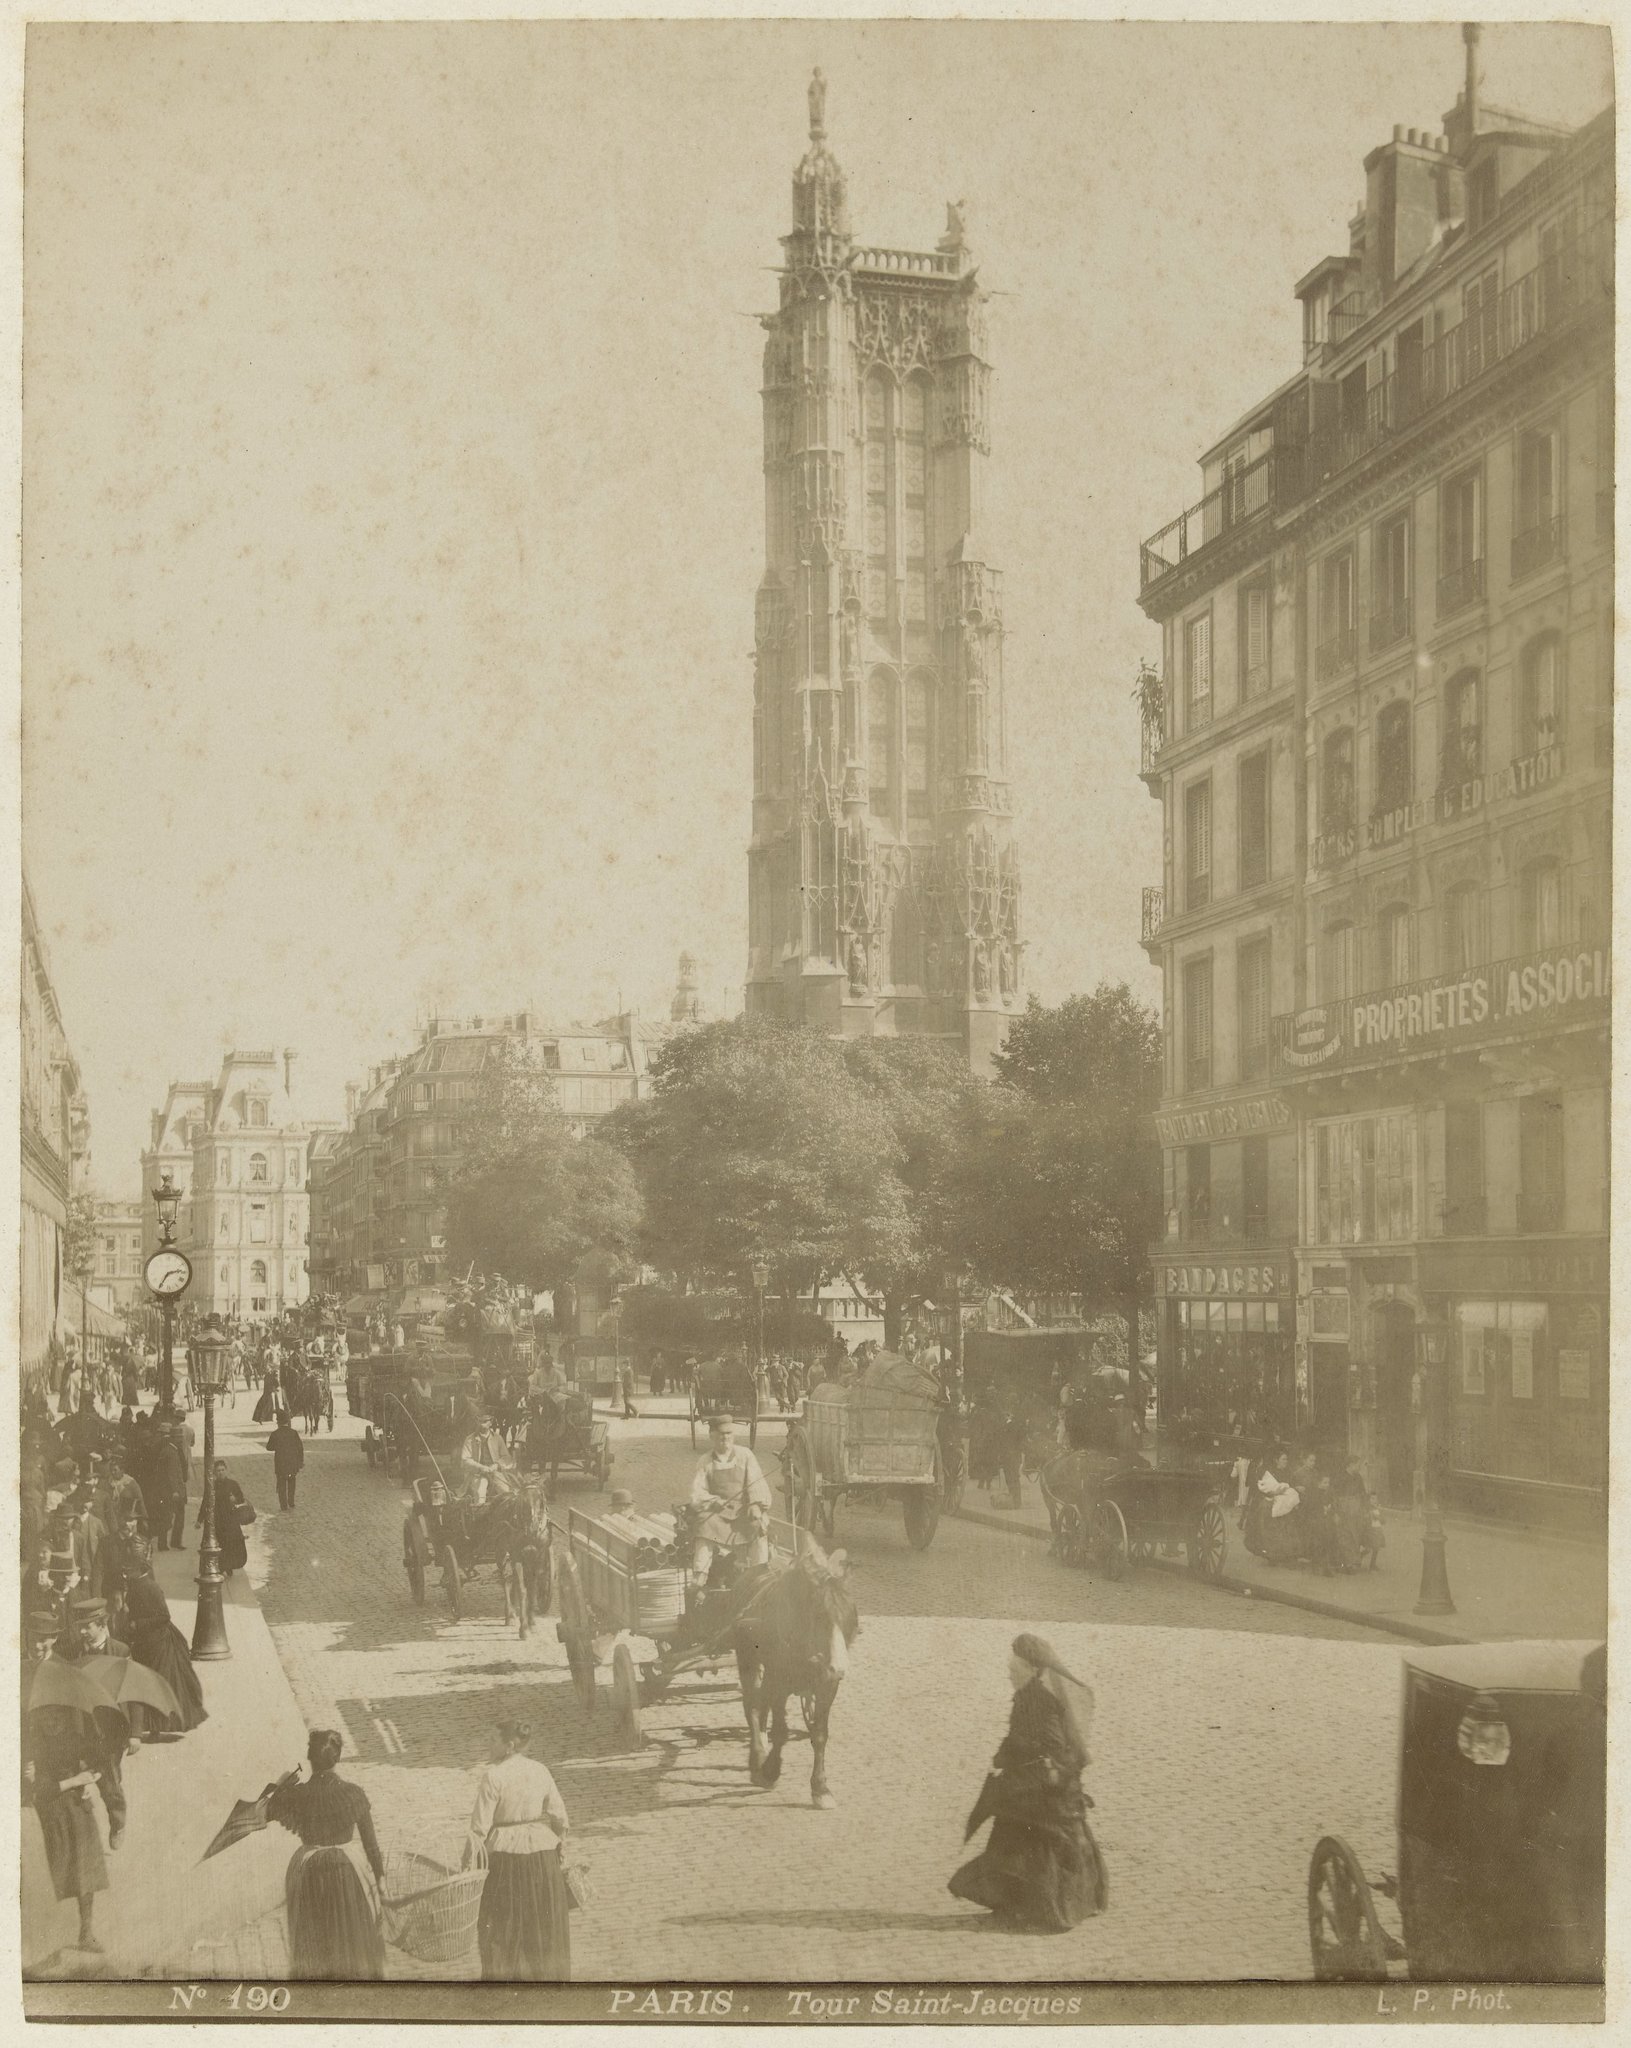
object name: photograph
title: Paris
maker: louis antoine pamard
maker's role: fotograaf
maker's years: 1840-1893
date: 1870-1900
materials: cardboard, paper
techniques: albumen print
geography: france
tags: street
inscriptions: number: ‘No 190’